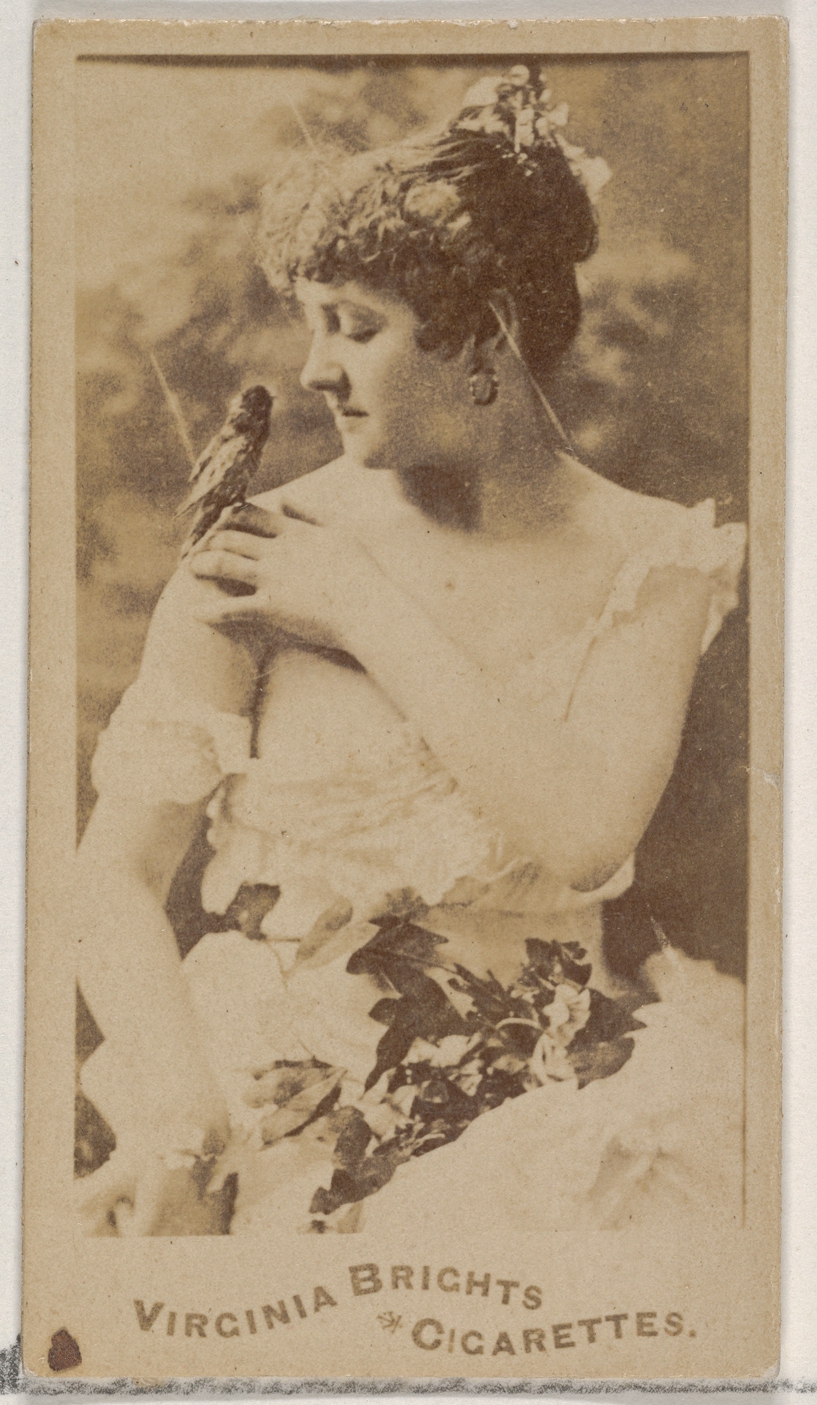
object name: photograph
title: From the Actors and Actresses series (N45, Type 5) for Virginia Brights Cigarettes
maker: allen & ginter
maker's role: publisher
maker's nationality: american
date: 1888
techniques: albumen silver print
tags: birds,portraits,women,actresses